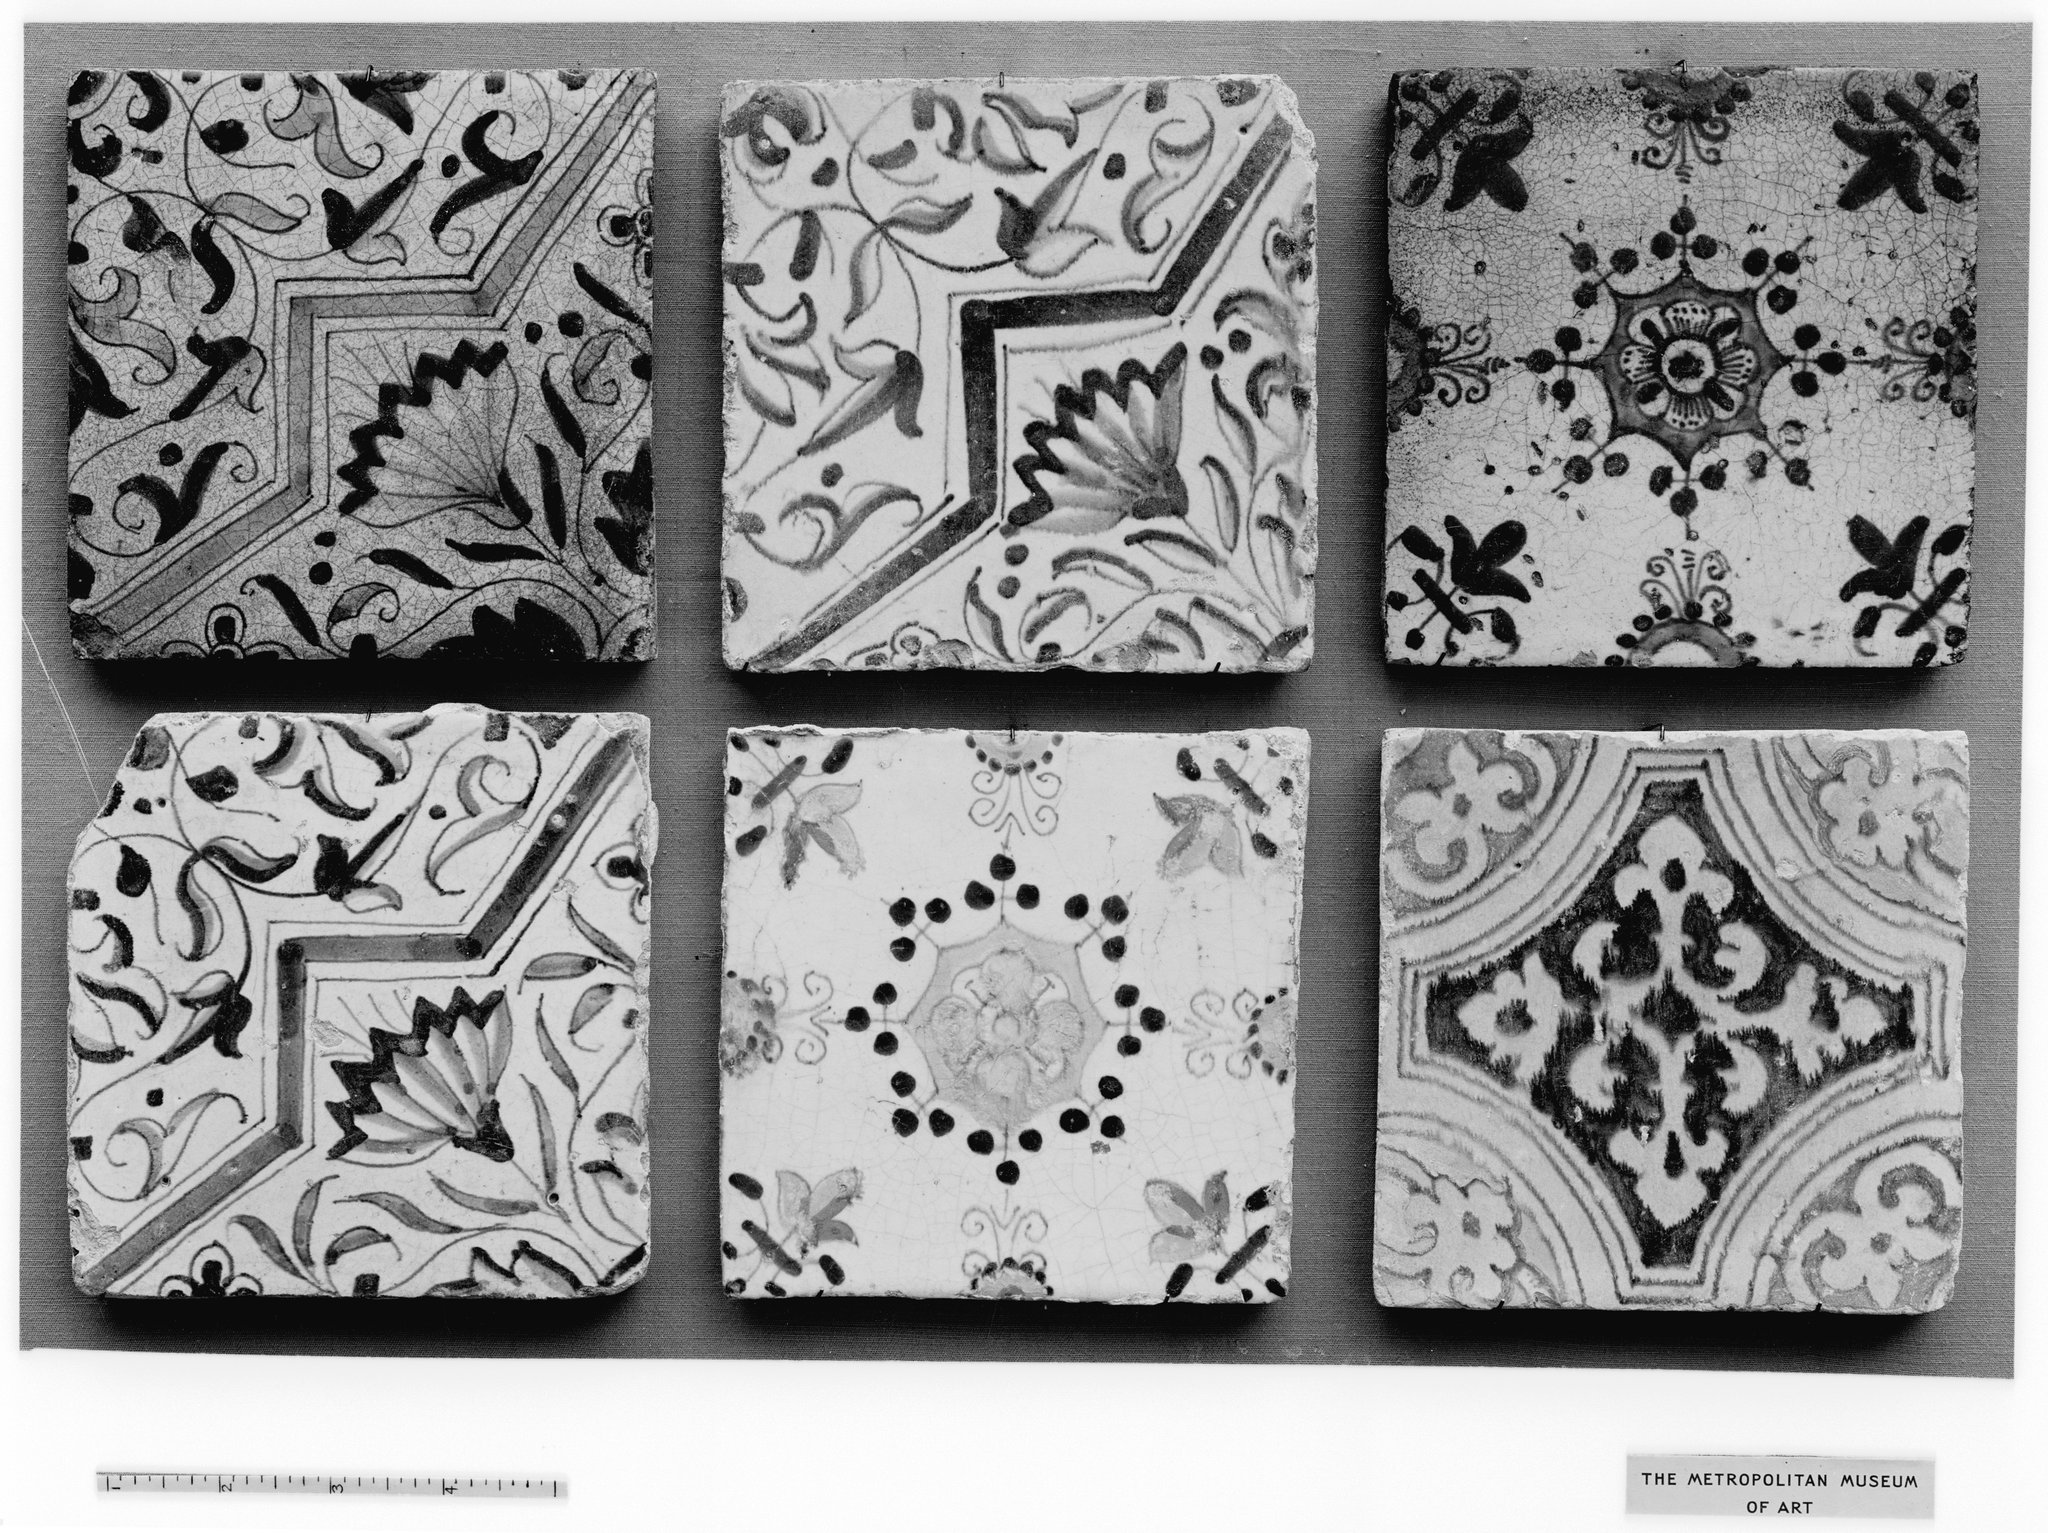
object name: tile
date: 1640-1660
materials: earthenware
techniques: glazing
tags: flowers